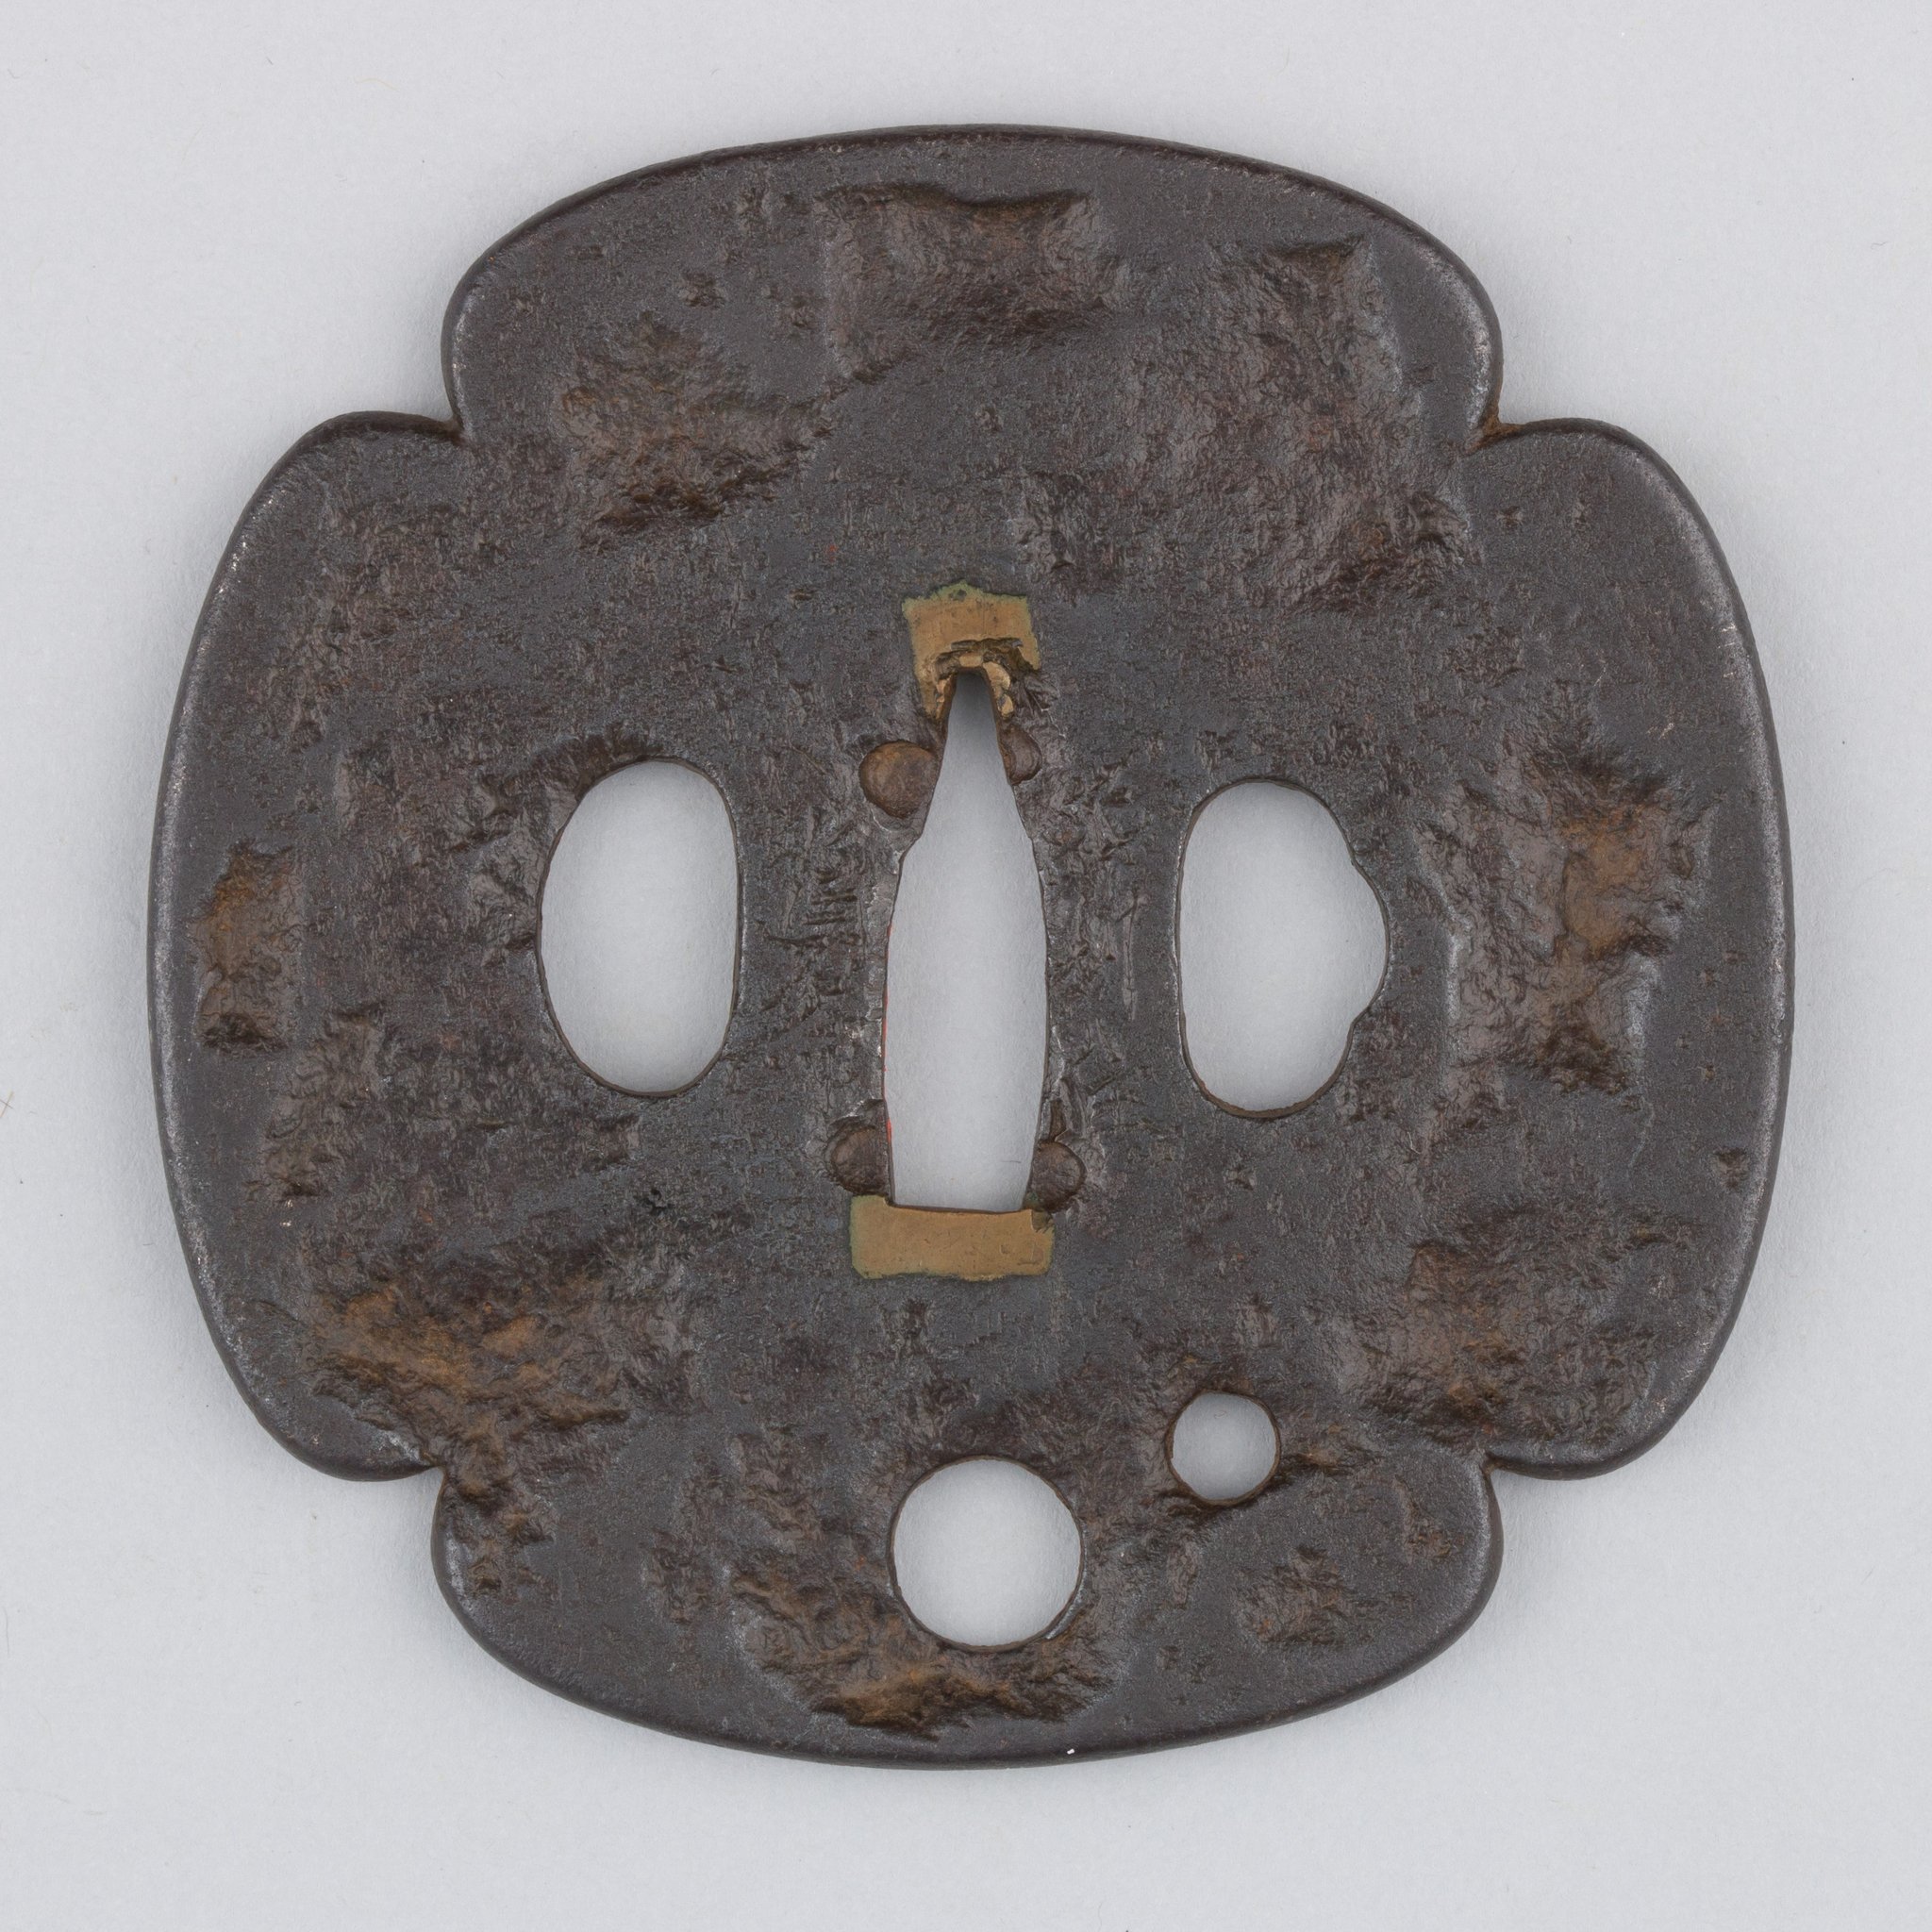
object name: sword guard tsuba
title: Sword Guard (Tsuba)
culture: japanese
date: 1667-1700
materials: copper, iron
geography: japan